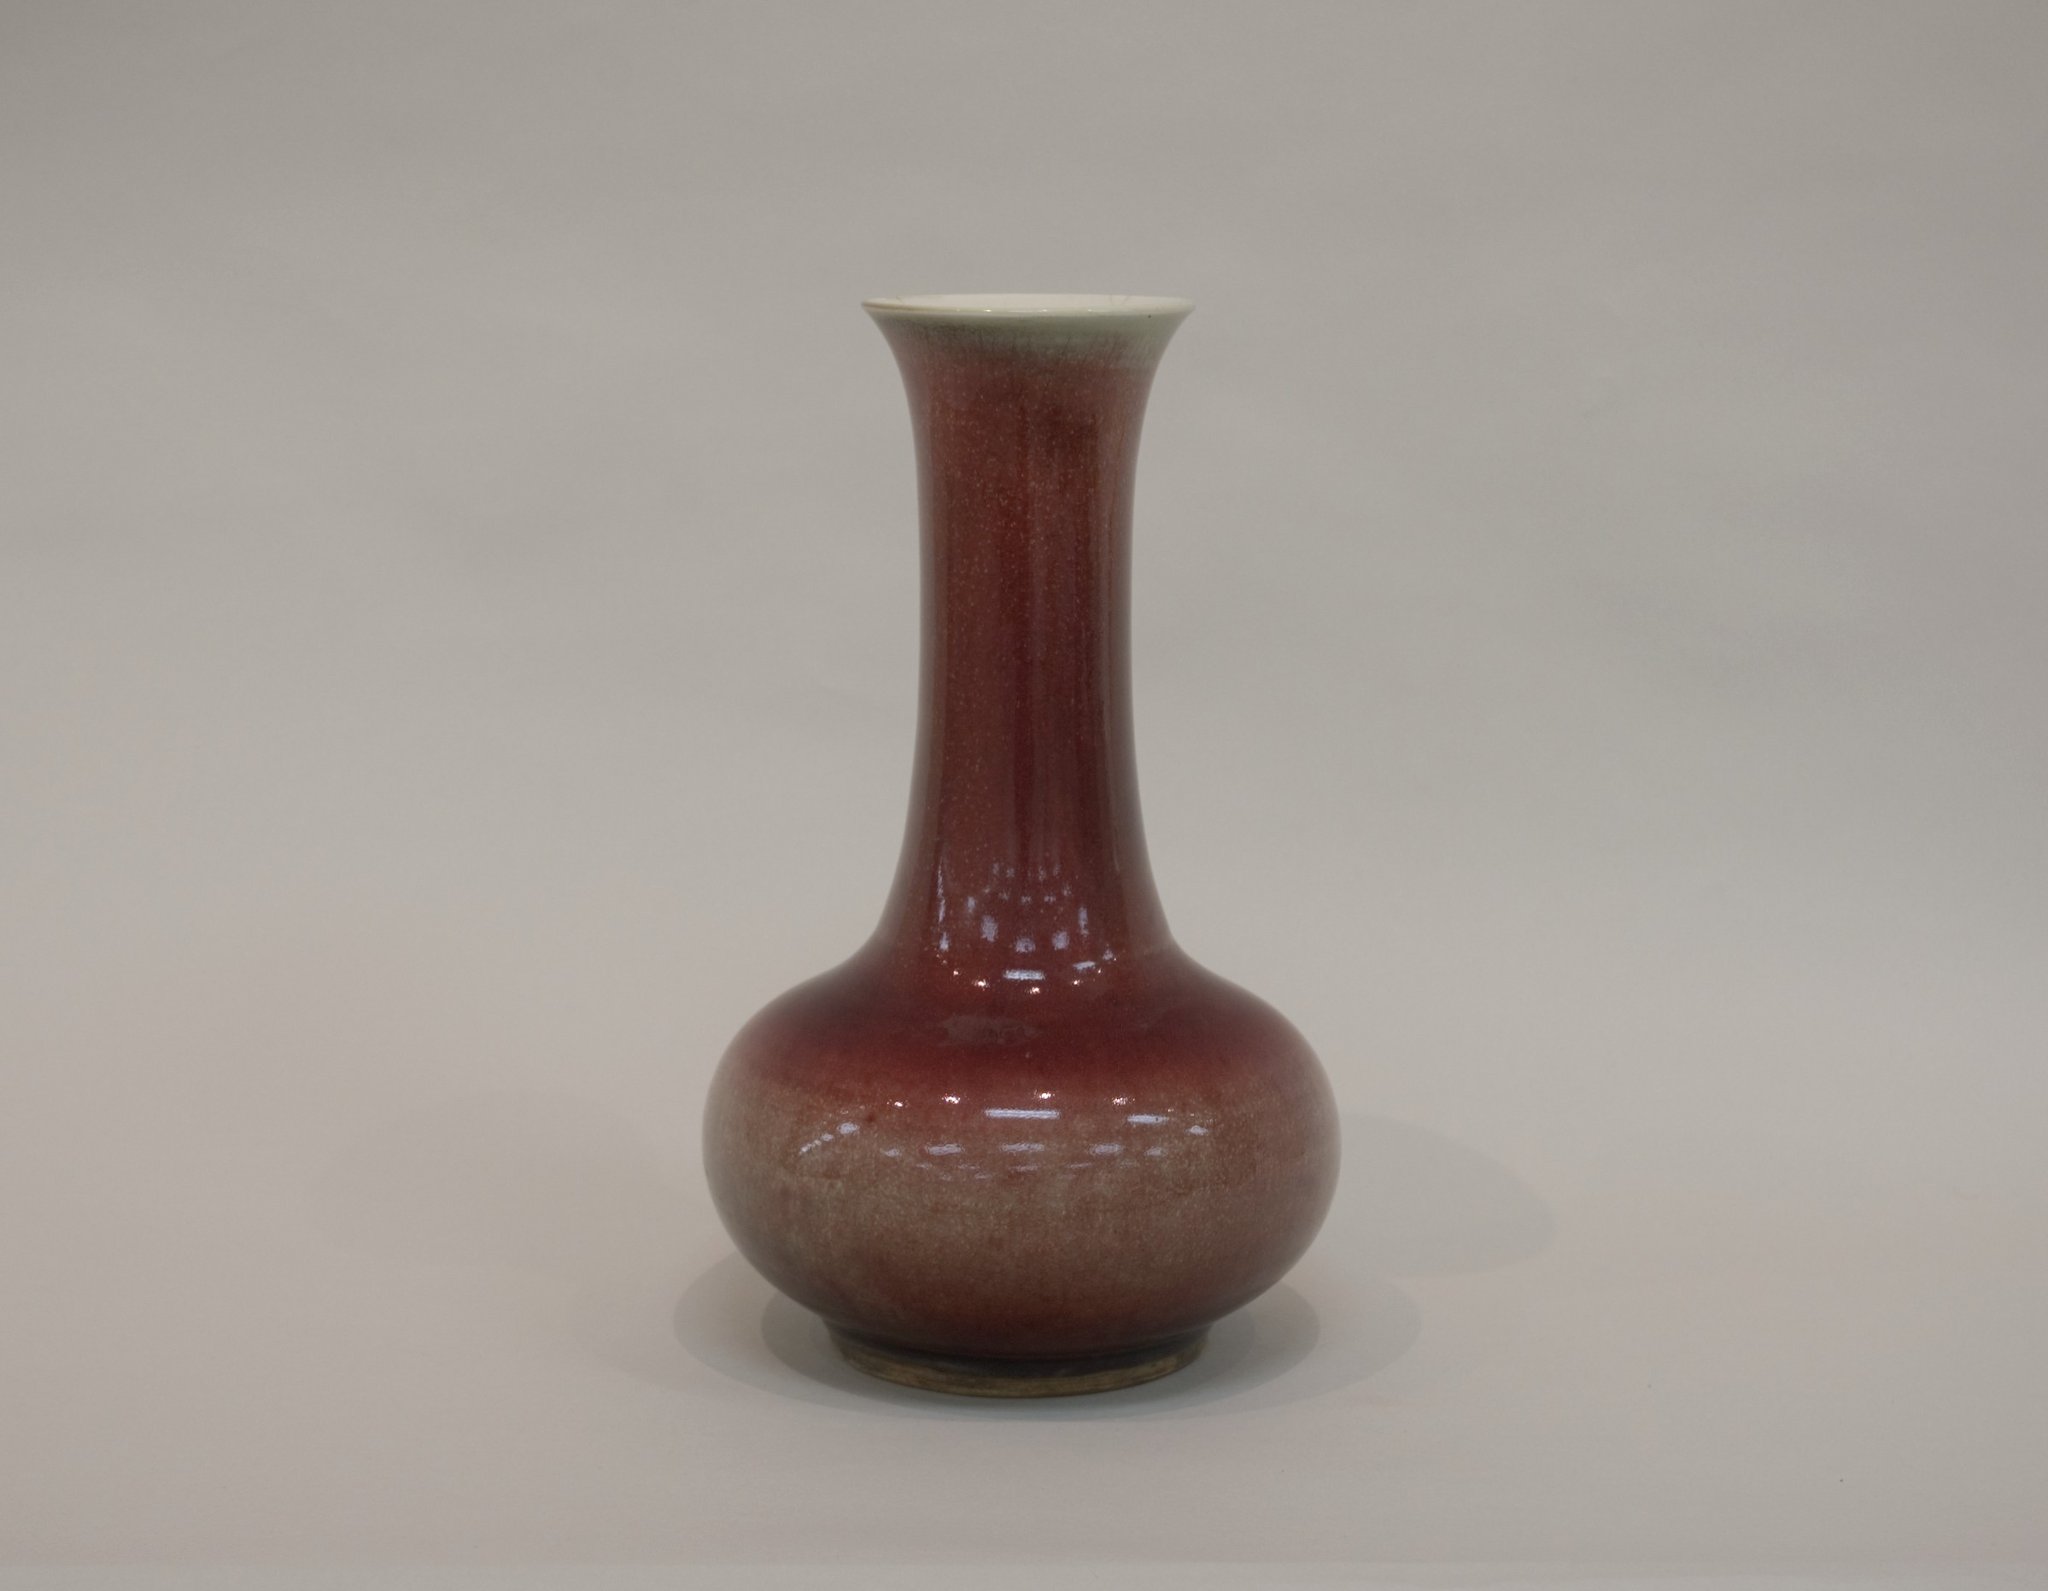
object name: bottle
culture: chinese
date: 1662-1722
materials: glaze, porcelain